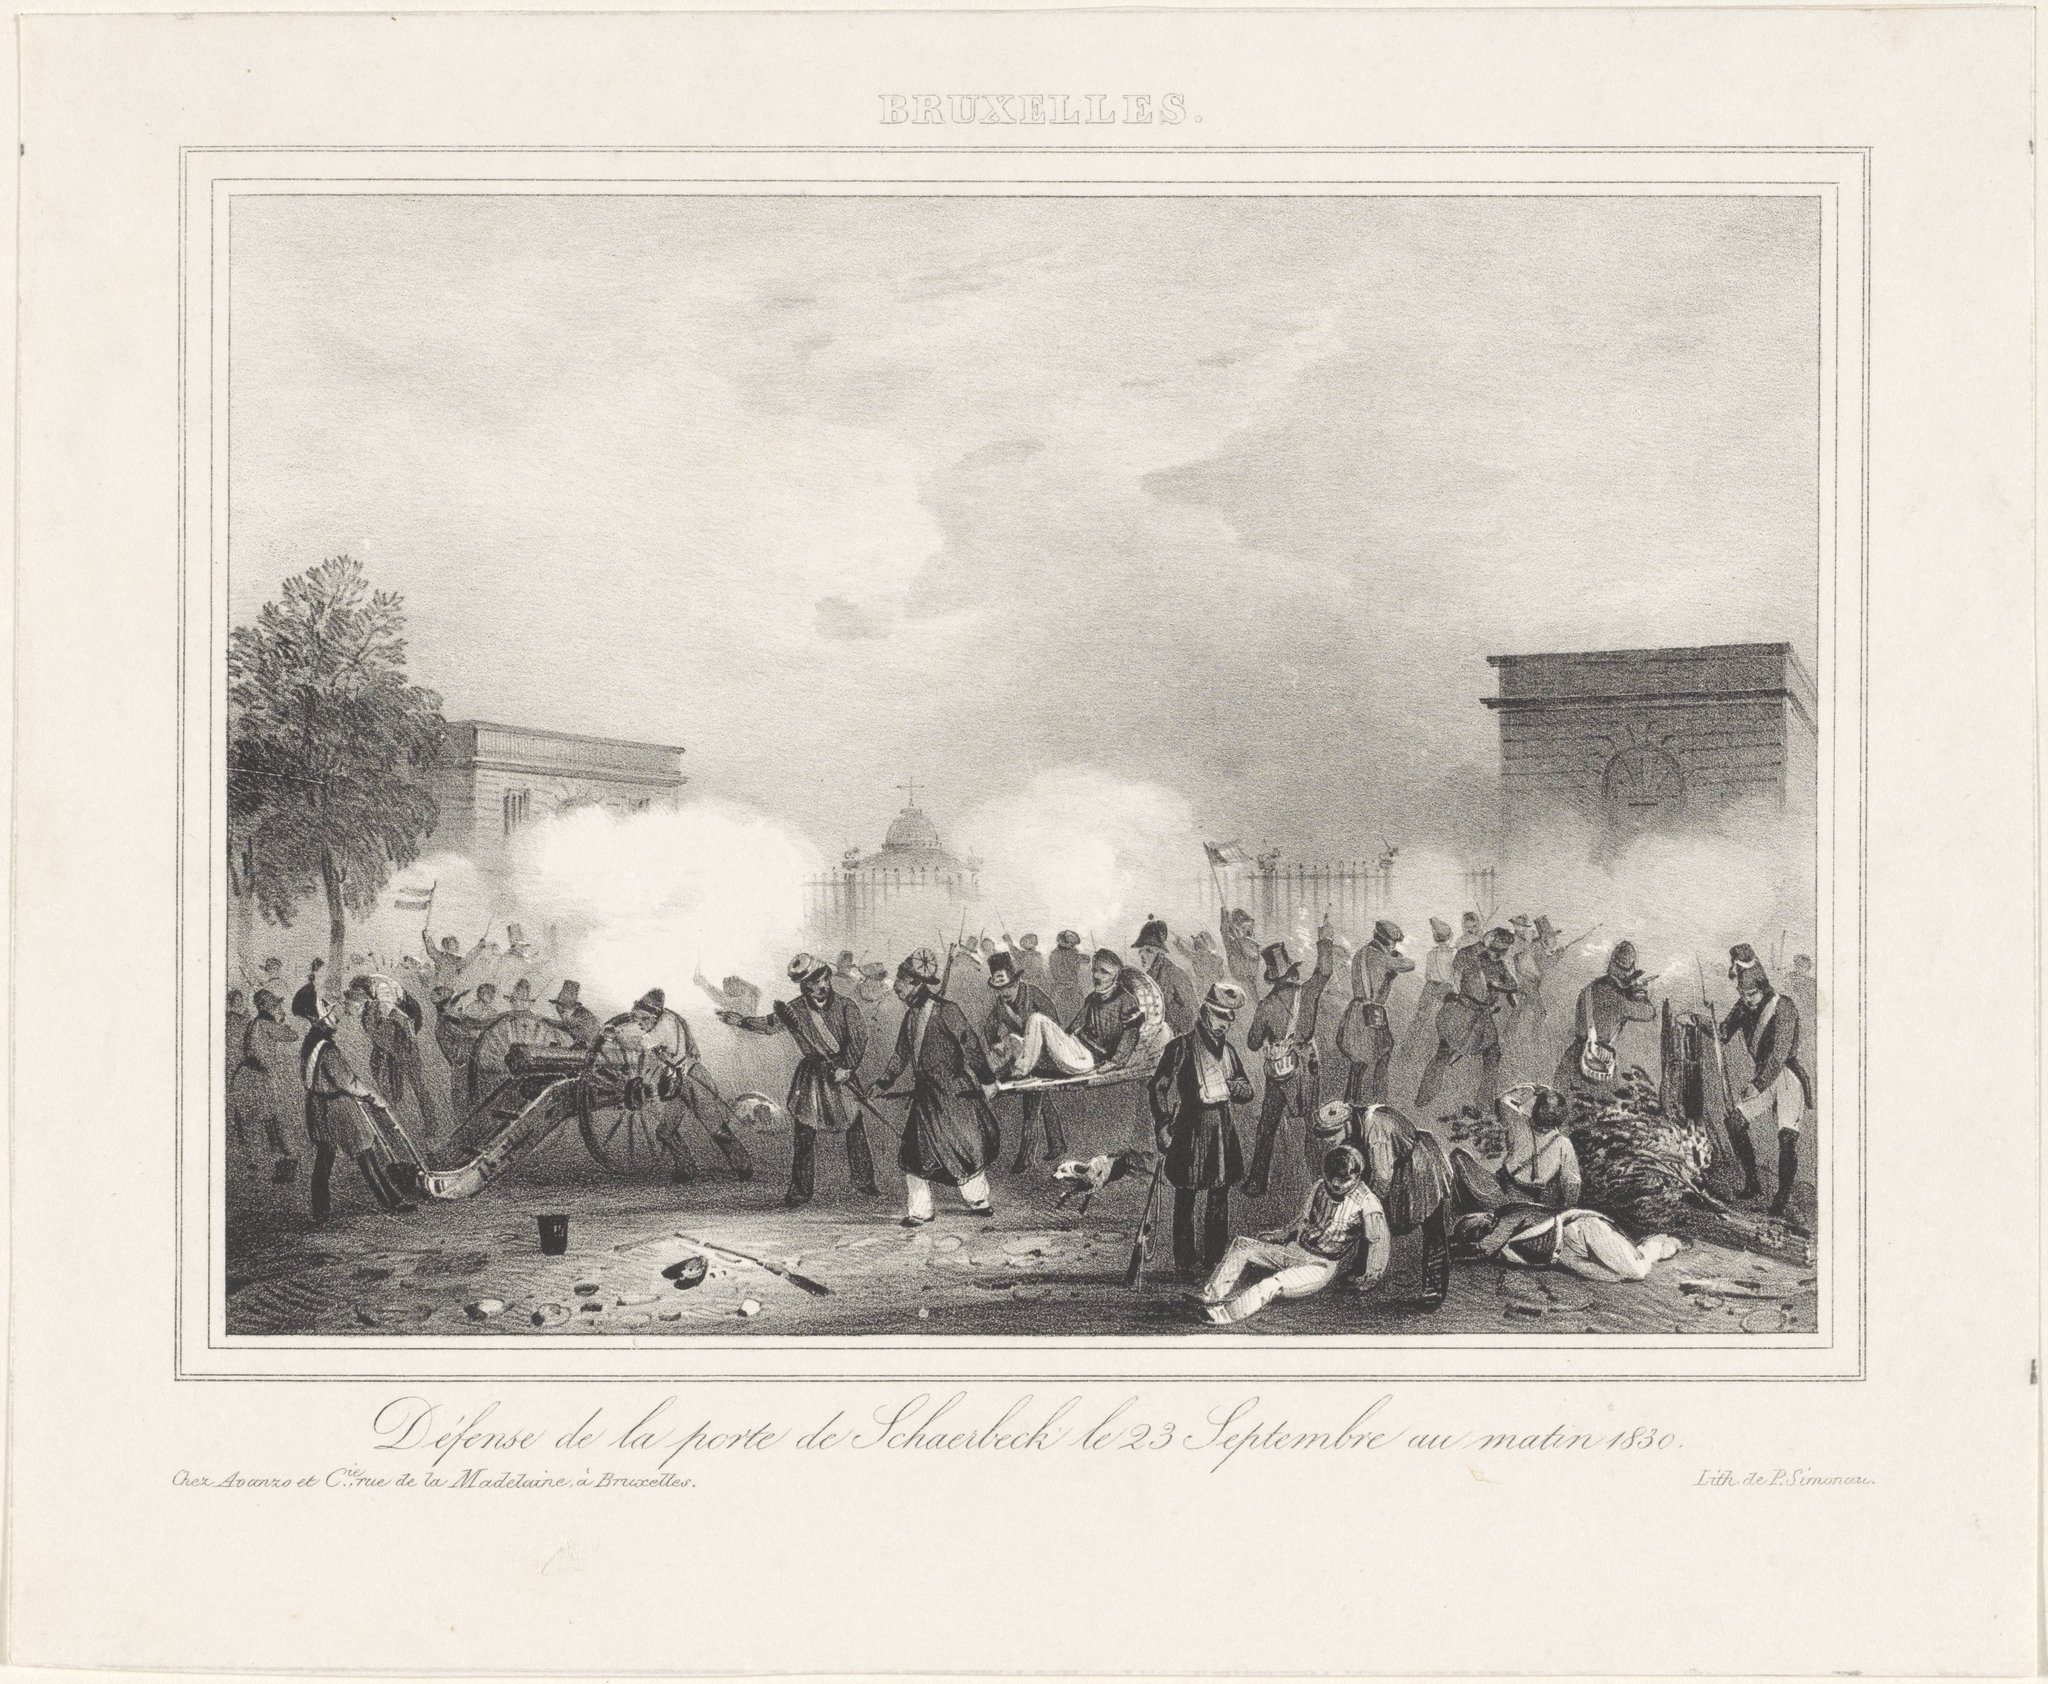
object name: print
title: Verdediging bij de Schaarbeeksepoort in Brussel, 1830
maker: pierre simonau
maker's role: printer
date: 1830-1831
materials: paper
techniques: lithograph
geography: brussels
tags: street-fights, riots, brussels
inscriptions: collector's mark: Lugt 2228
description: Belgische opstandelingen verdedigen de Schaarbeekse Poort in Brussel, 23 september 1830. Onderdeel van een groep van prenten uit verschillende andere series verwant aan de platen in het recueil over de gebeurtenissen tijdens de Belgische Revolutie in Brussel, Antwerpen en andere steden in de periode 25 augustus 1830 tot 27 maart 1831.